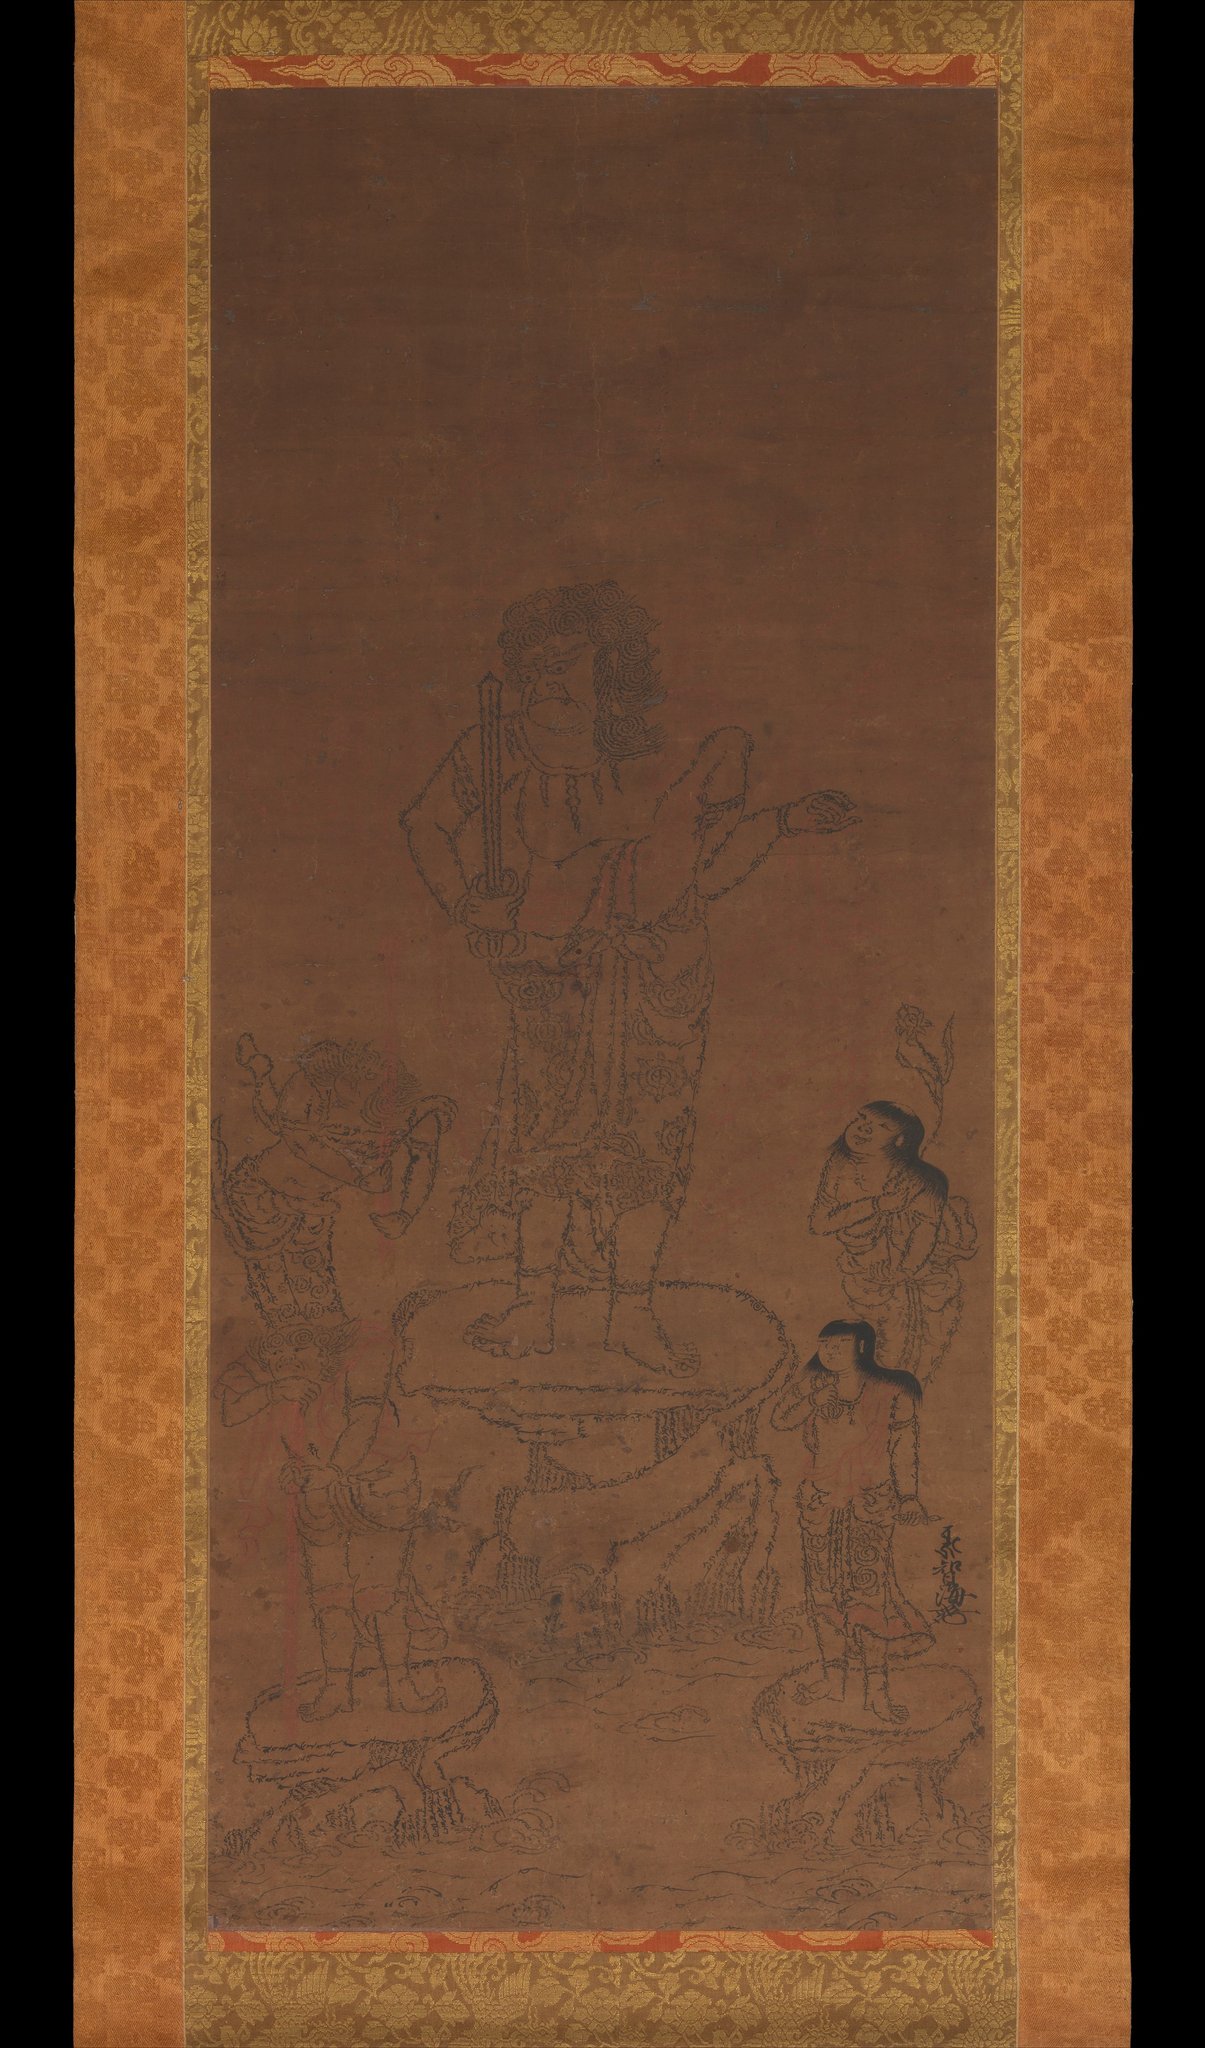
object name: hanging scroll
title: Fudō Myōō with Four Attendants, Outlined in Seed Syllables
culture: japanese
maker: chikai 智海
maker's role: artist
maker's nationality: japanese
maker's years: 1422-1503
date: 1451-1500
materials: ink, paper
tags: men,deities